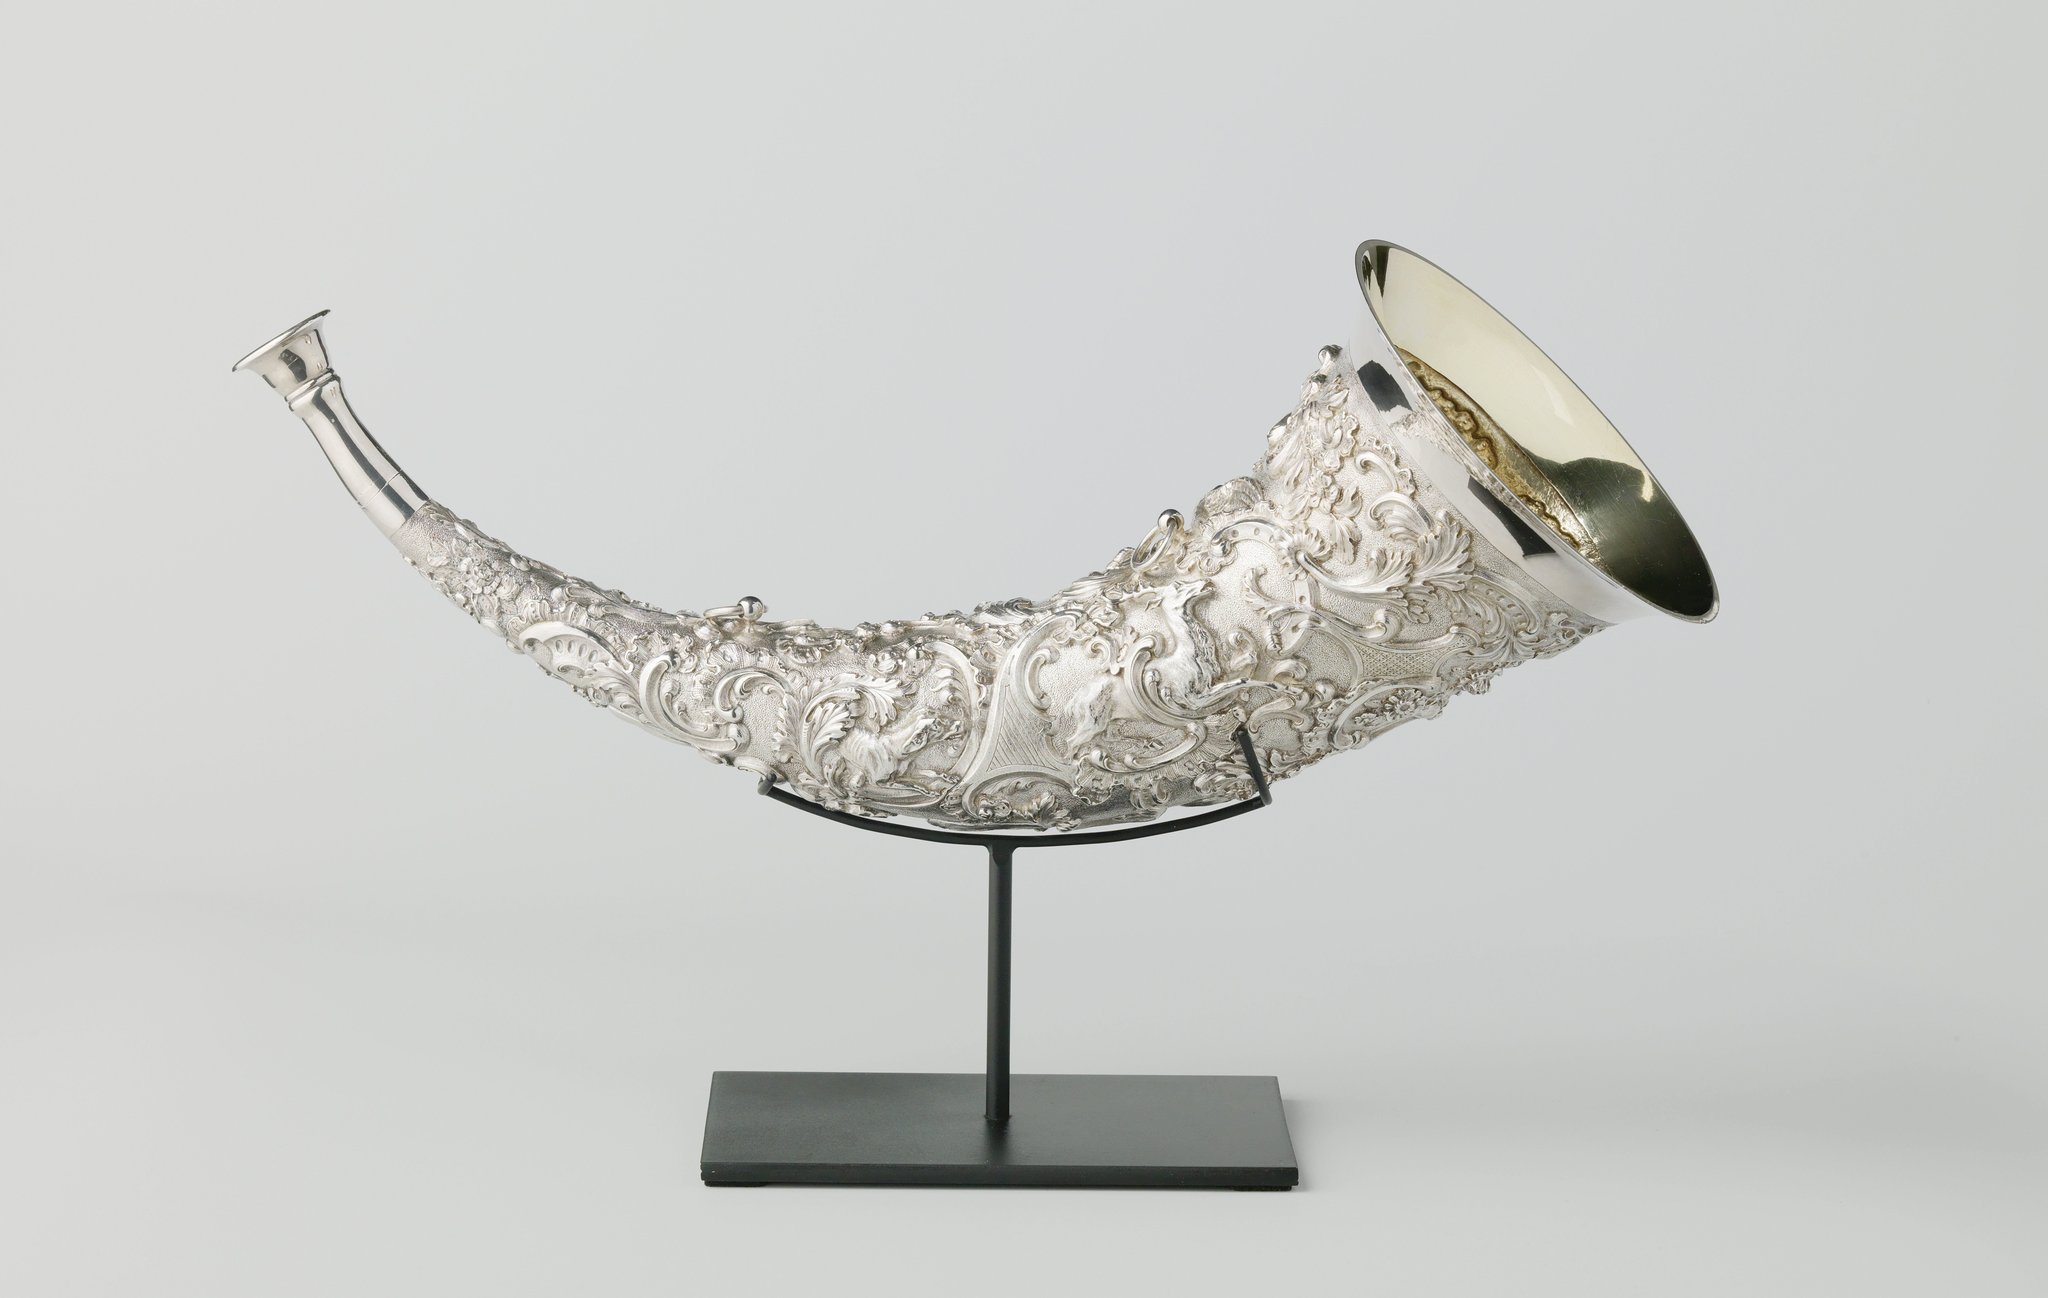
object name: musical instrument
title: Hunting horn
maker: johannes mattheus van kempen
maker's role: silversmith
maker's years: 1814-1877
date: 1849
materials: silver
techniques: gilding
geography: utrecht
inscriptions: alloy mark: ‘staande leeuw met 1’, maker's mark: ‘meesterteken VK boven 47 in vierkant’, mark: ‘Minervakop met u’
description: In 1849 King William II presented this horn as a prize for the fastest hunter at Het Loo Palace. Its shape is derived from an ox horn, and is embellished with both predators and prey. Concealed in the asymmetrical Rococo scrolls are a red deer beset by a hound, a fox cornered by a pair of lions, and a hooded falcon waits to hunt its prey.